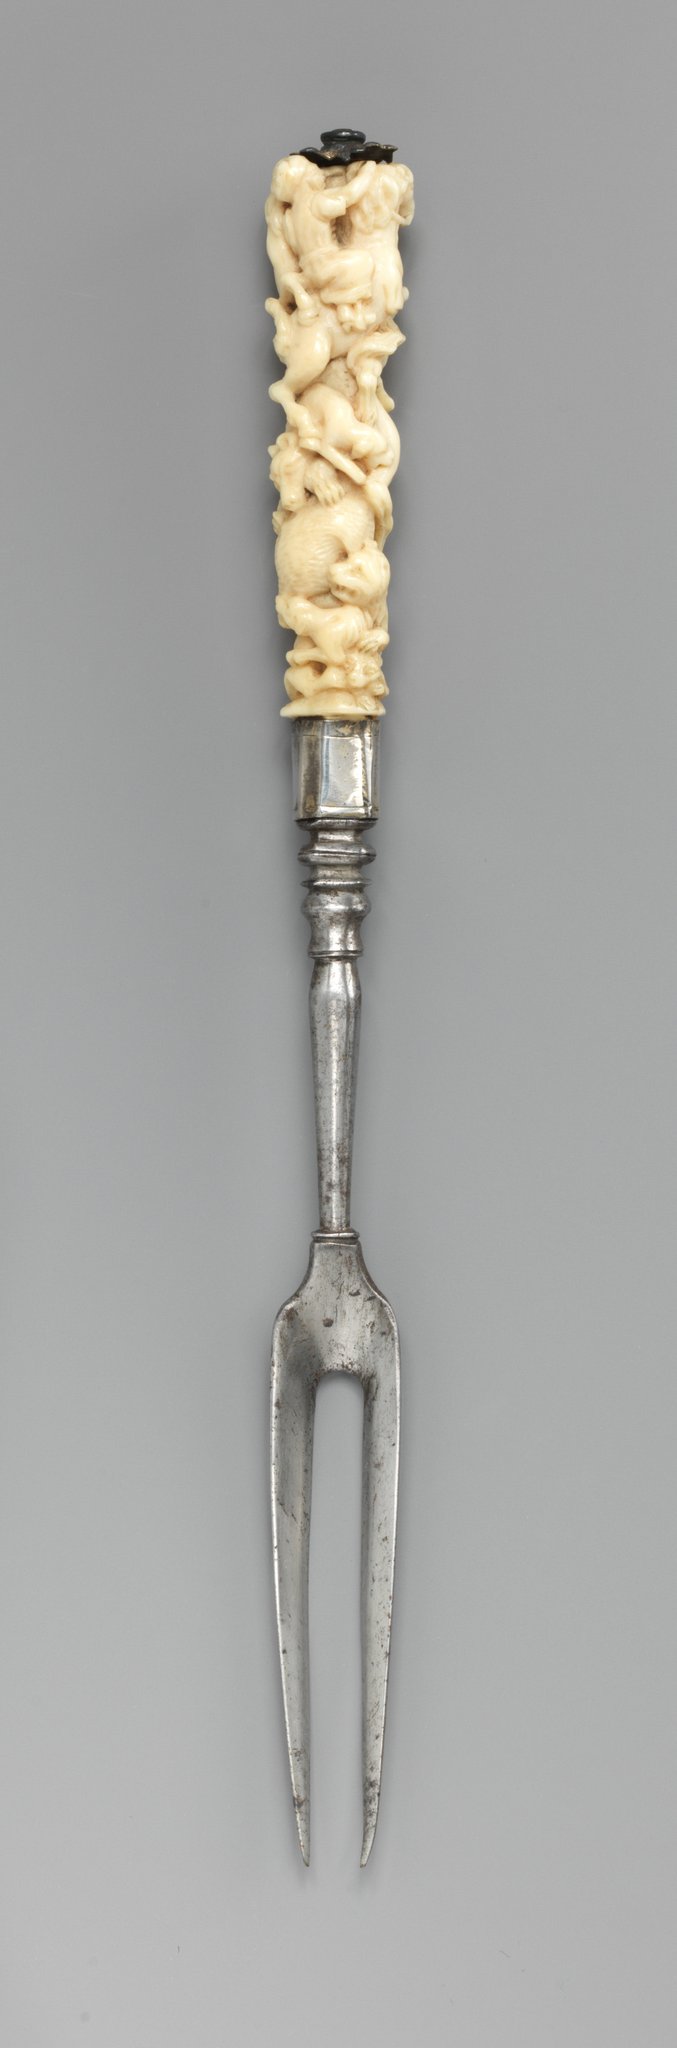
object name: fork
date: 1667-1733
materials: ivory, silver, steel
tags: animals,horses